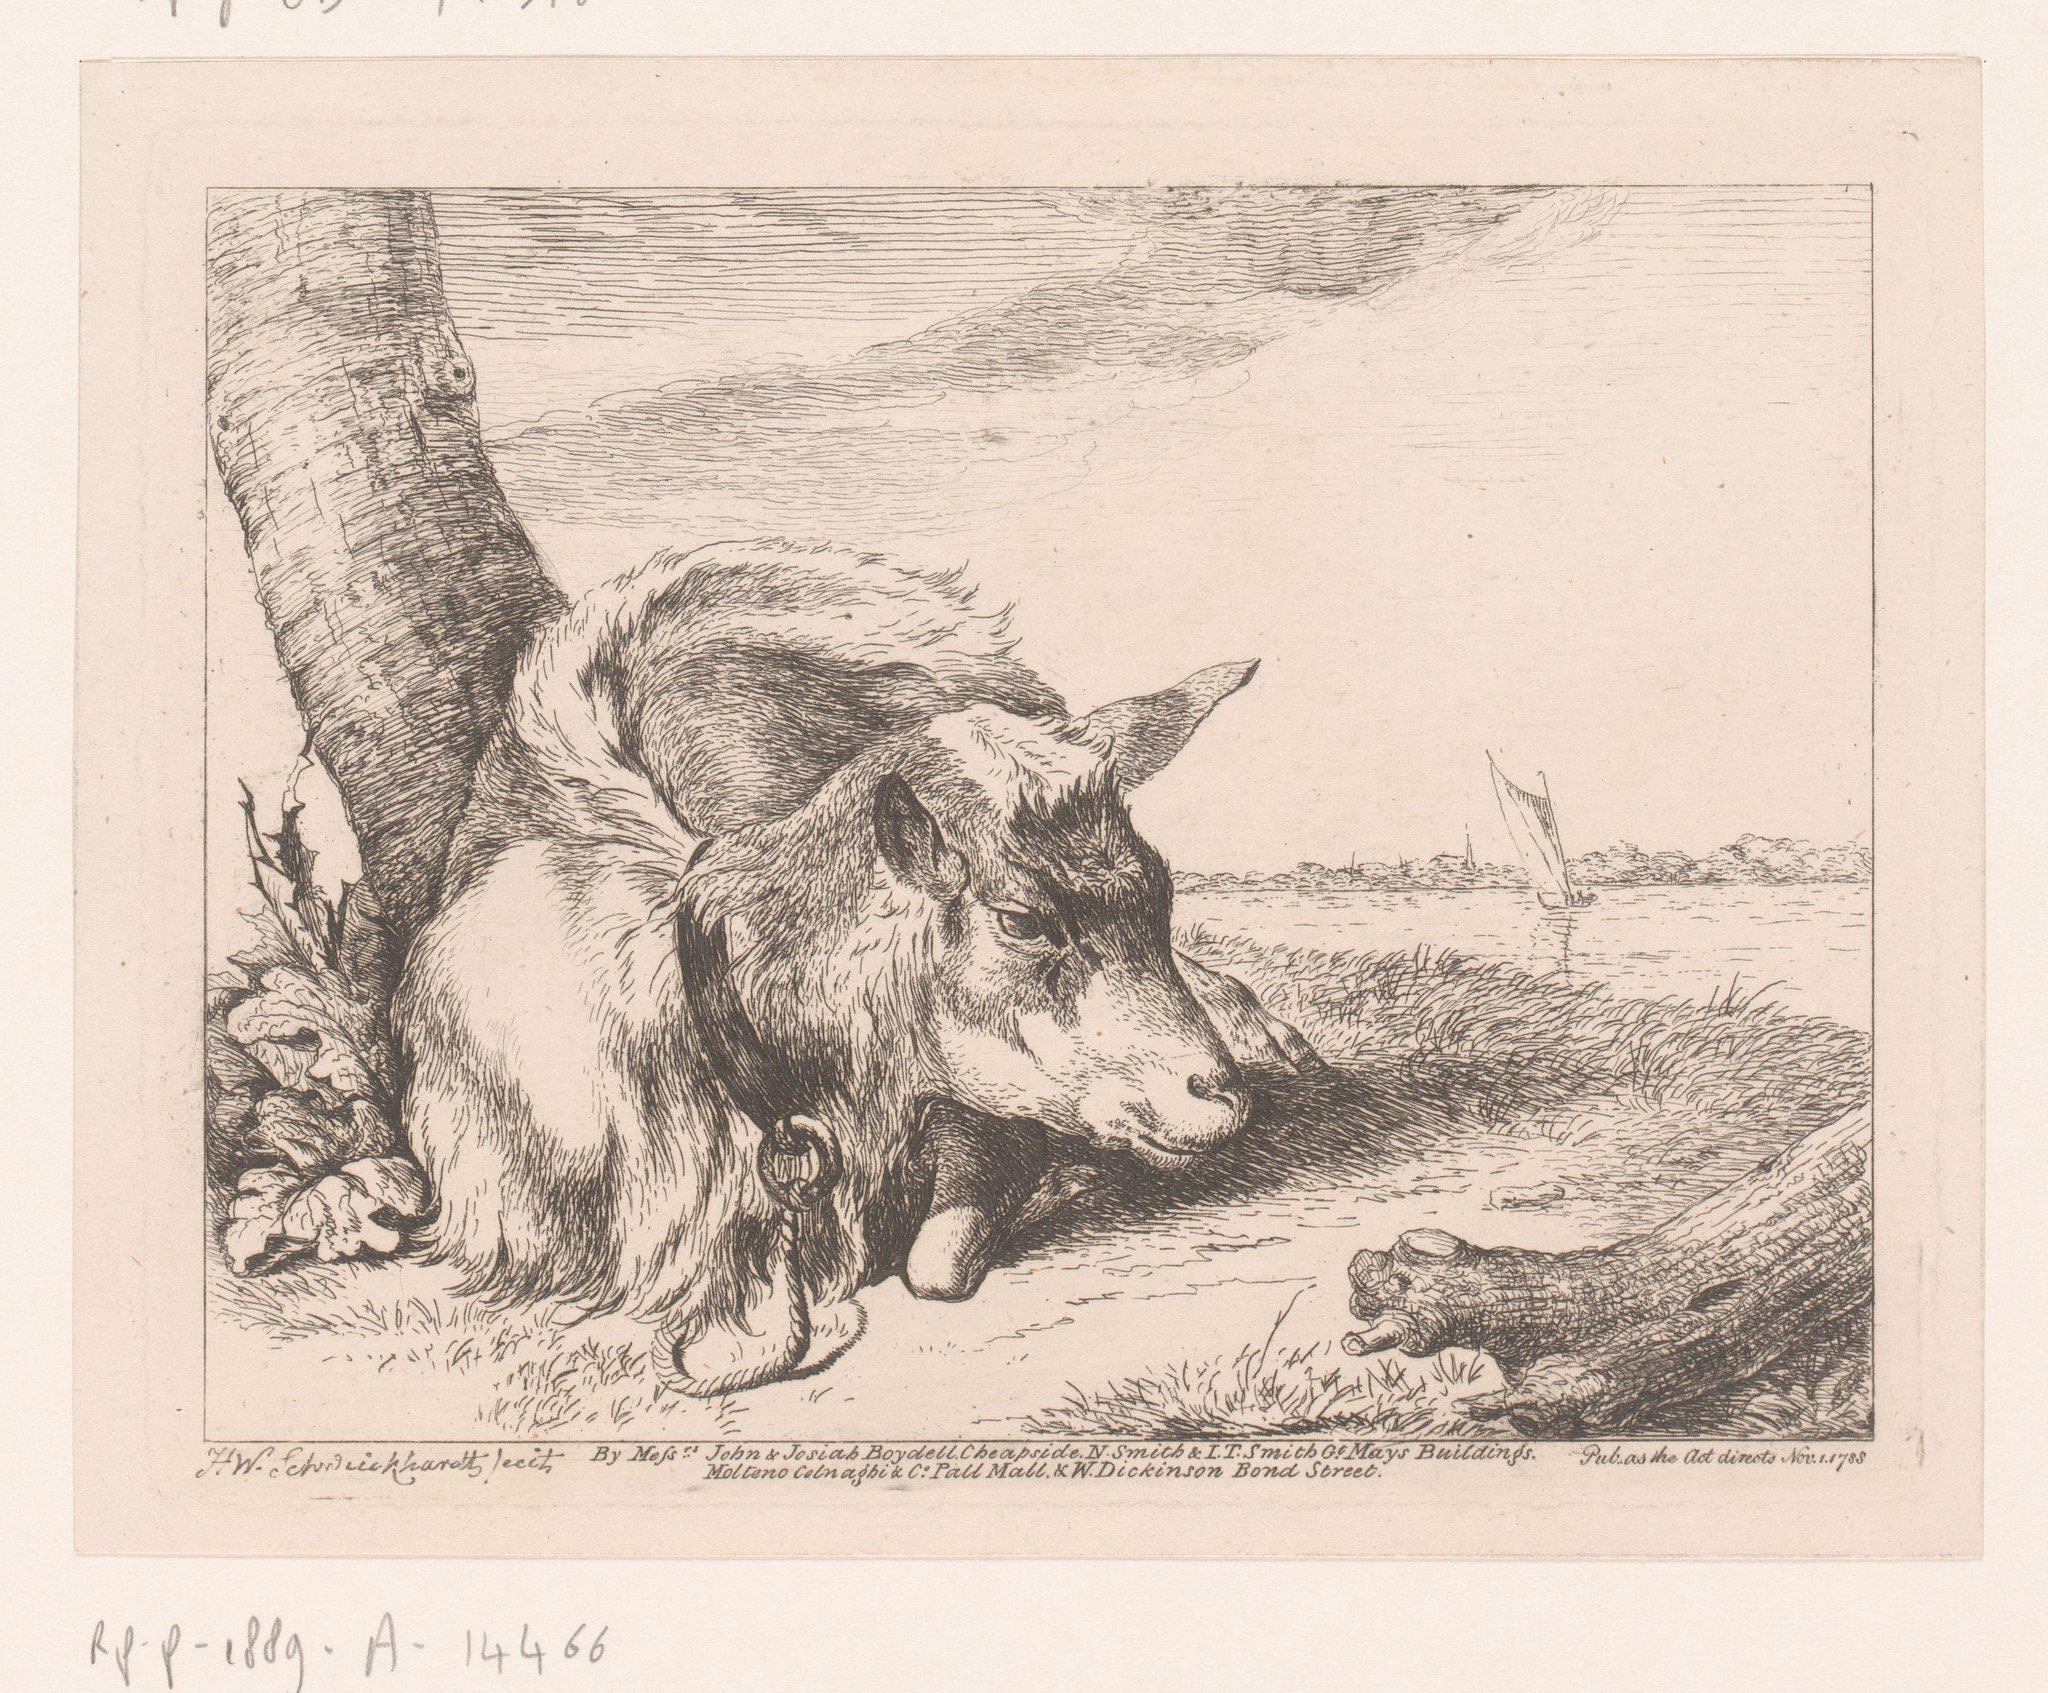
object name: print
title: Liggende geit bij water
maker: hendrik willem schweickhardt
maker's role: draughtsman, painter, print maker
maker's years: 1746-1797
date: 1788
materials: paper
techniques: etching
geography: england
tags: animals, goat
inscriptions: collector's mark: Lugt 2228, name: ‘H.W. Scheickhardt’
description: Behoort tot een serie van acht prenten met verschillende dieren.